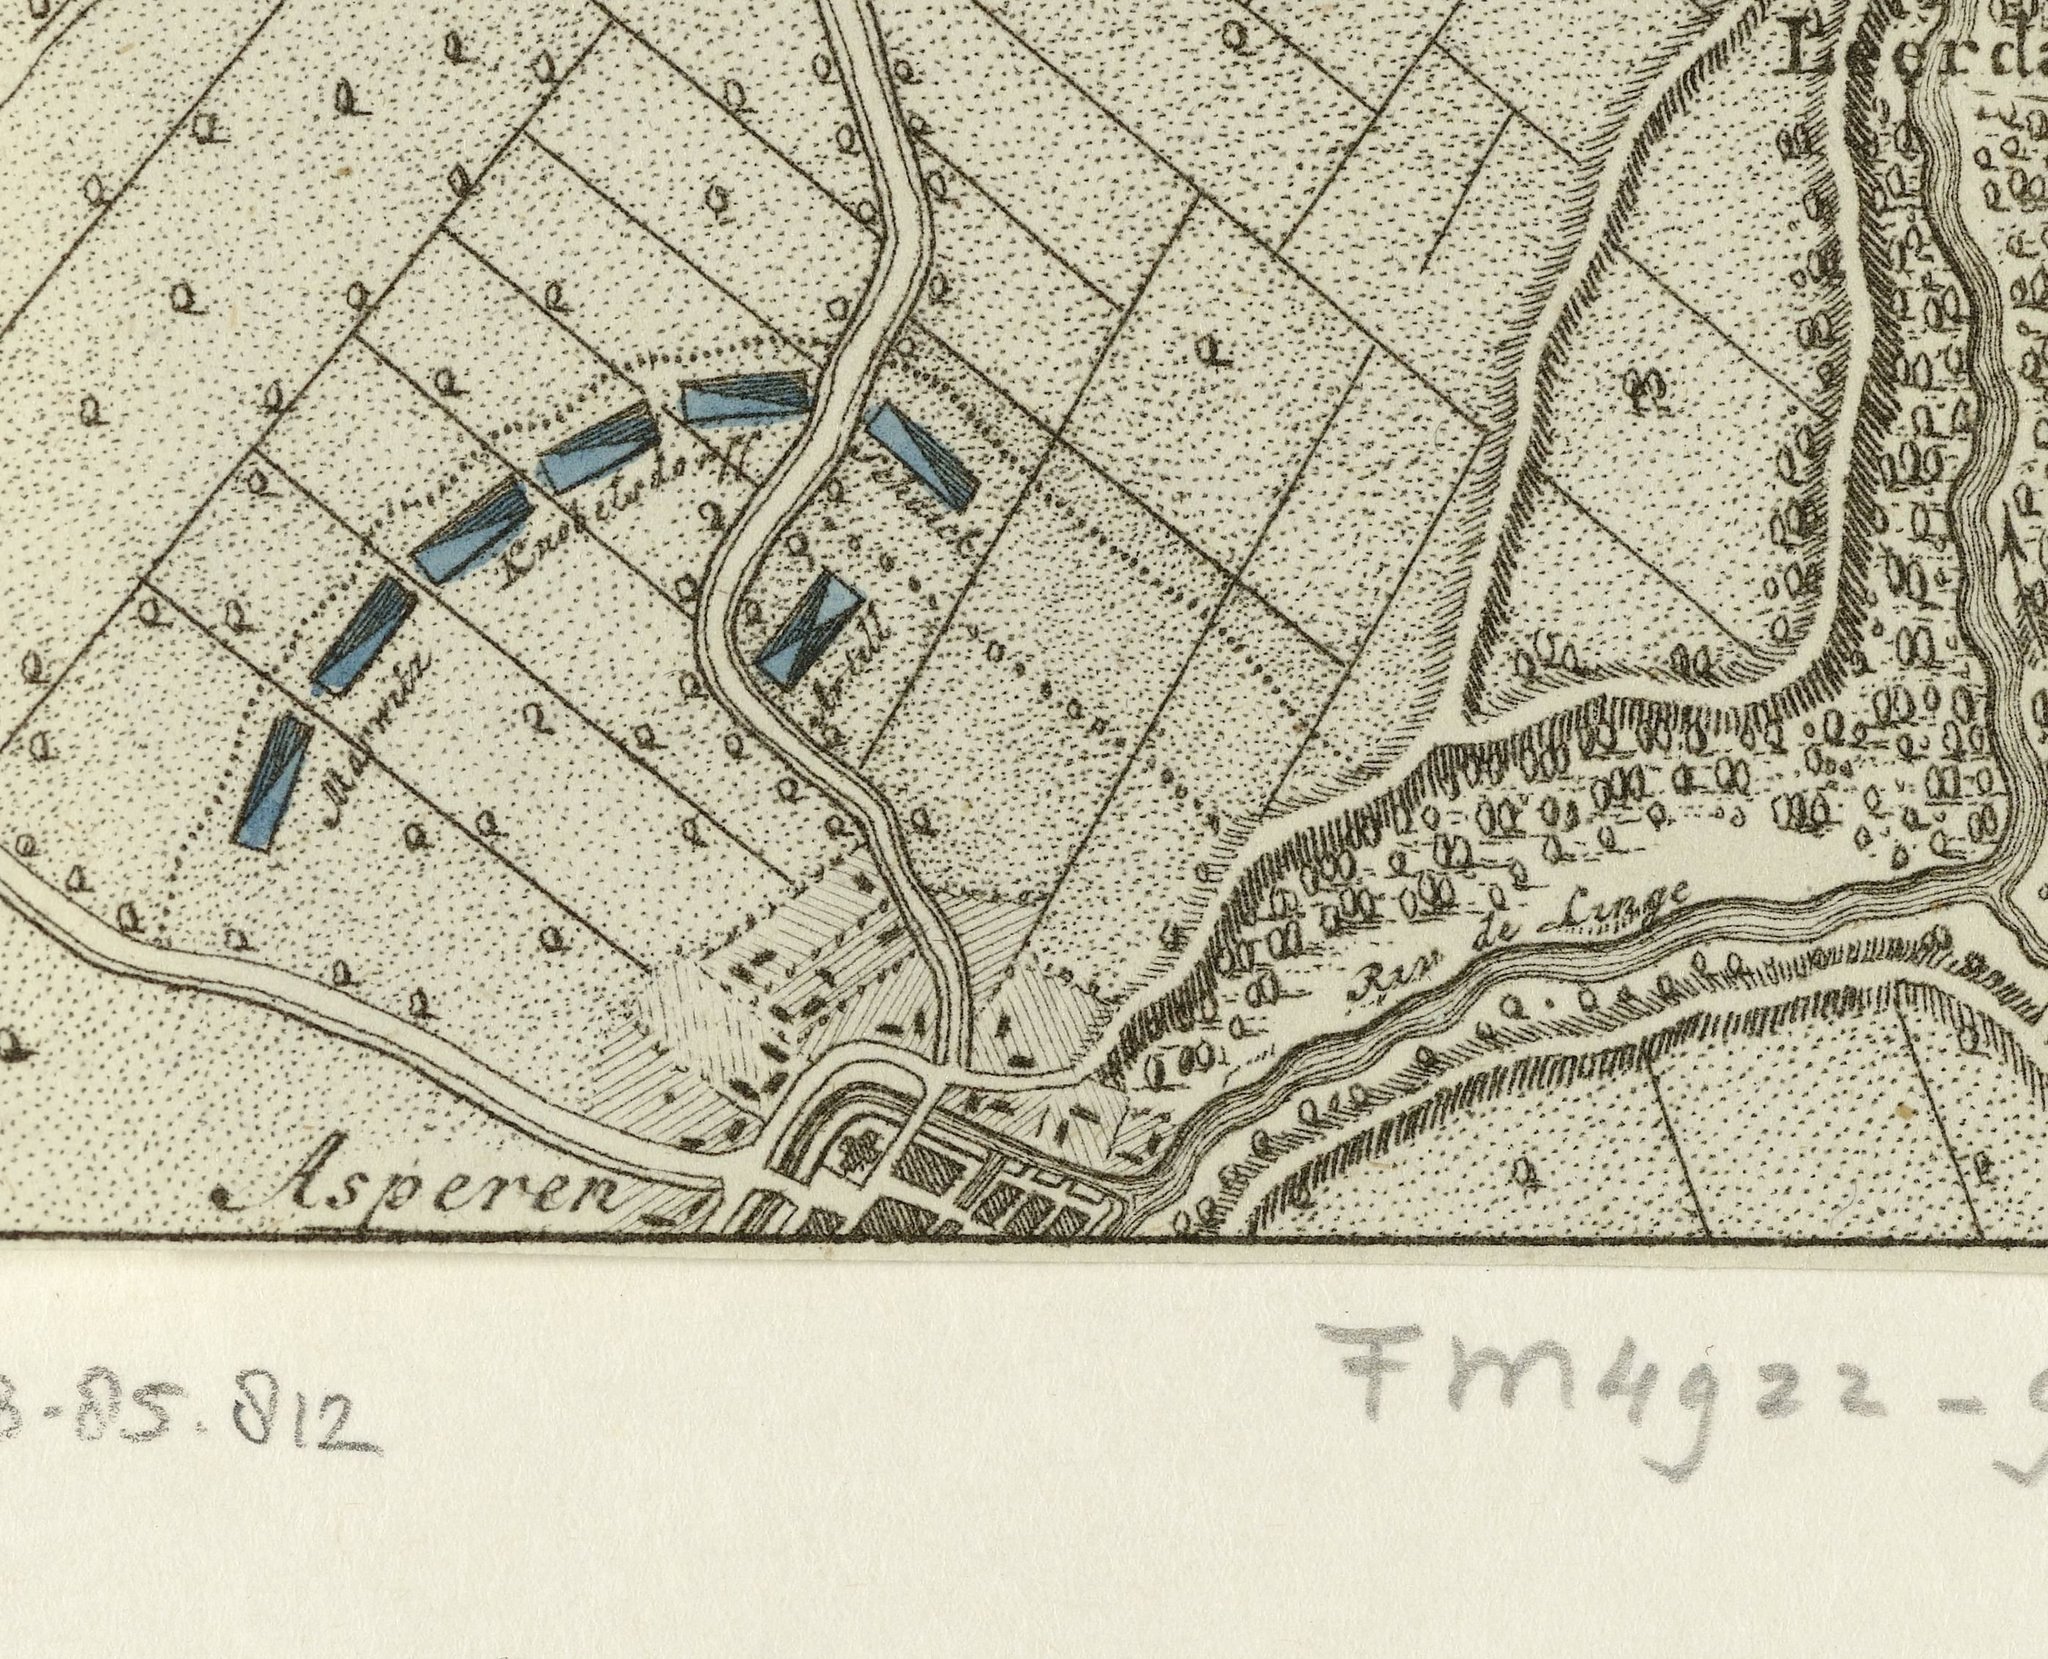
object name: book illustration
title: Kampement van de Pruisen te Asperen, 1787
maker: Anonymous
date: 1790-1792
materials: paper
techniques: etching, hand coloring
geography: northern netherlands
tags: maps of cities, asperen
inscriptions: collector's mark: Lugt 2228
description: Kaart met de ligging van het kampement van de Pruisische troepen bij Asperen op 16 september 1787. Onderdeel van een groep van veertien genummerde kaartjes van de kampementen van de Pruisische troepen tijdens de interventie in de Nederlanden in september 1787.